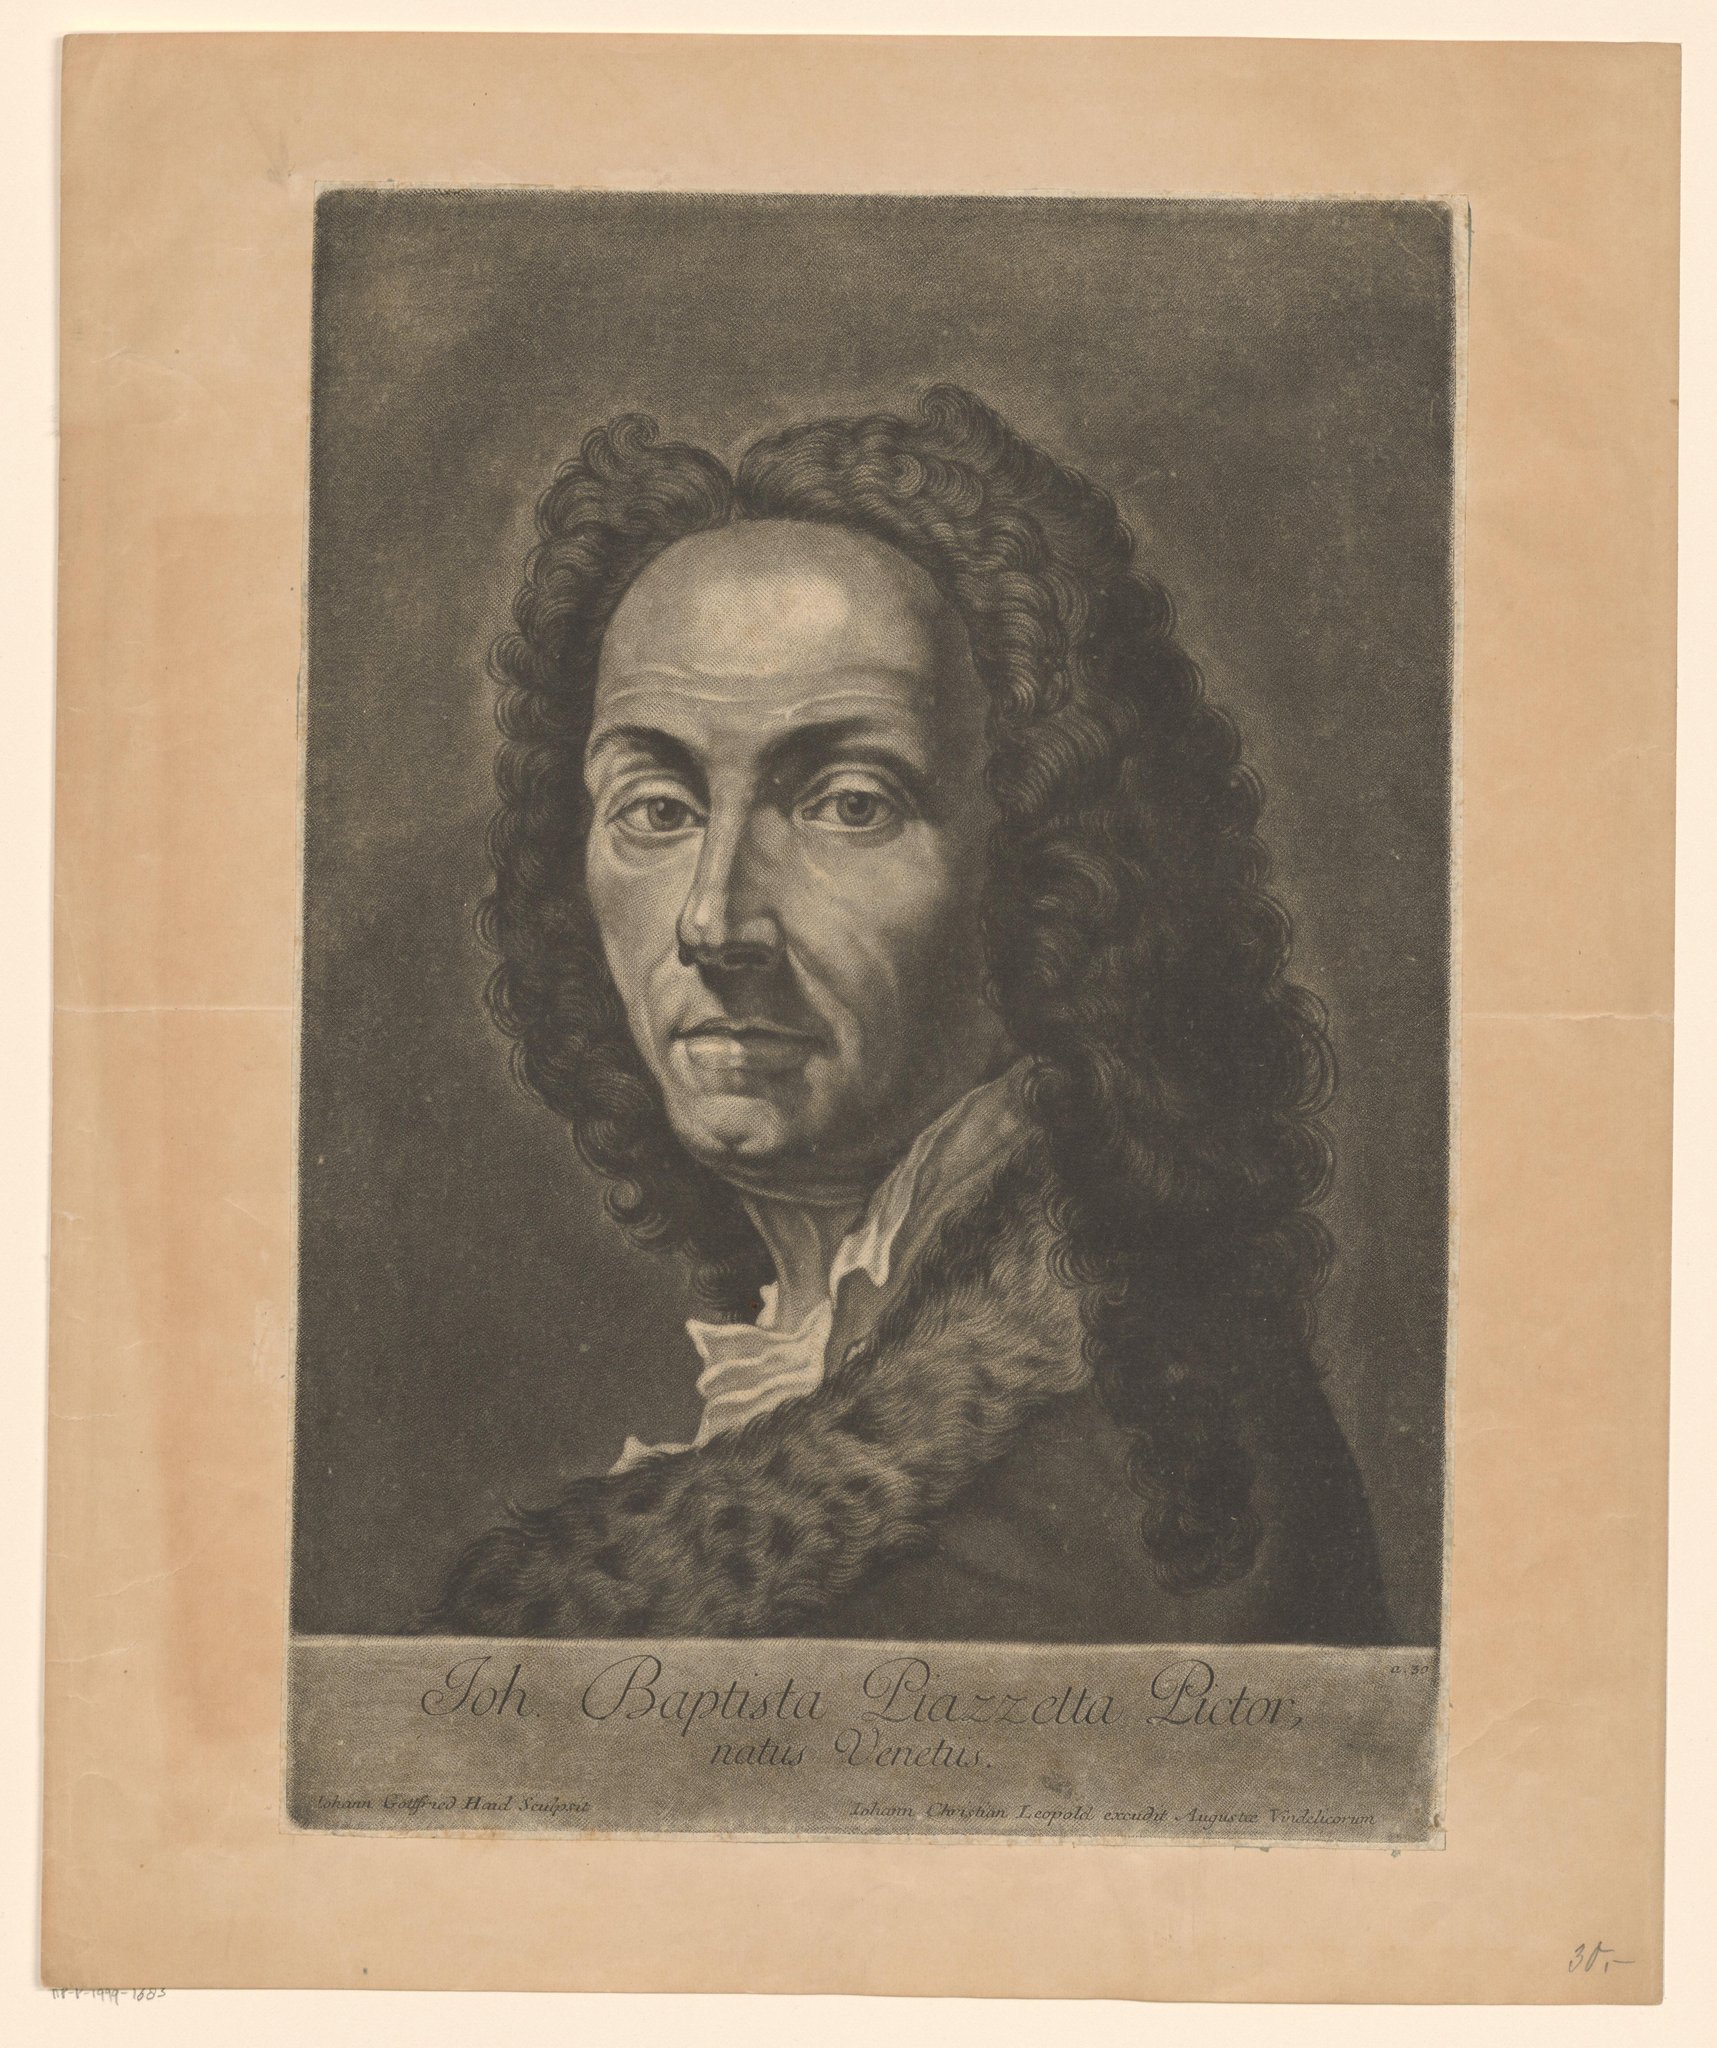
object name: print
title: Portret van Giovanni Battista Piazzetta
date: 1720-1755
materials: paper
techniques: engraving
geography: augsburg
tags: venice, painter, print maker, giovanni battista piazzetta, historical persons, portrait, self-portrait of painter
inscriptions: collector's mark: Lugt 2228, inscription: ‘Portr. 54375/ Piazetta/ LB XXII 401525’, collector's mark: Lugt 2760